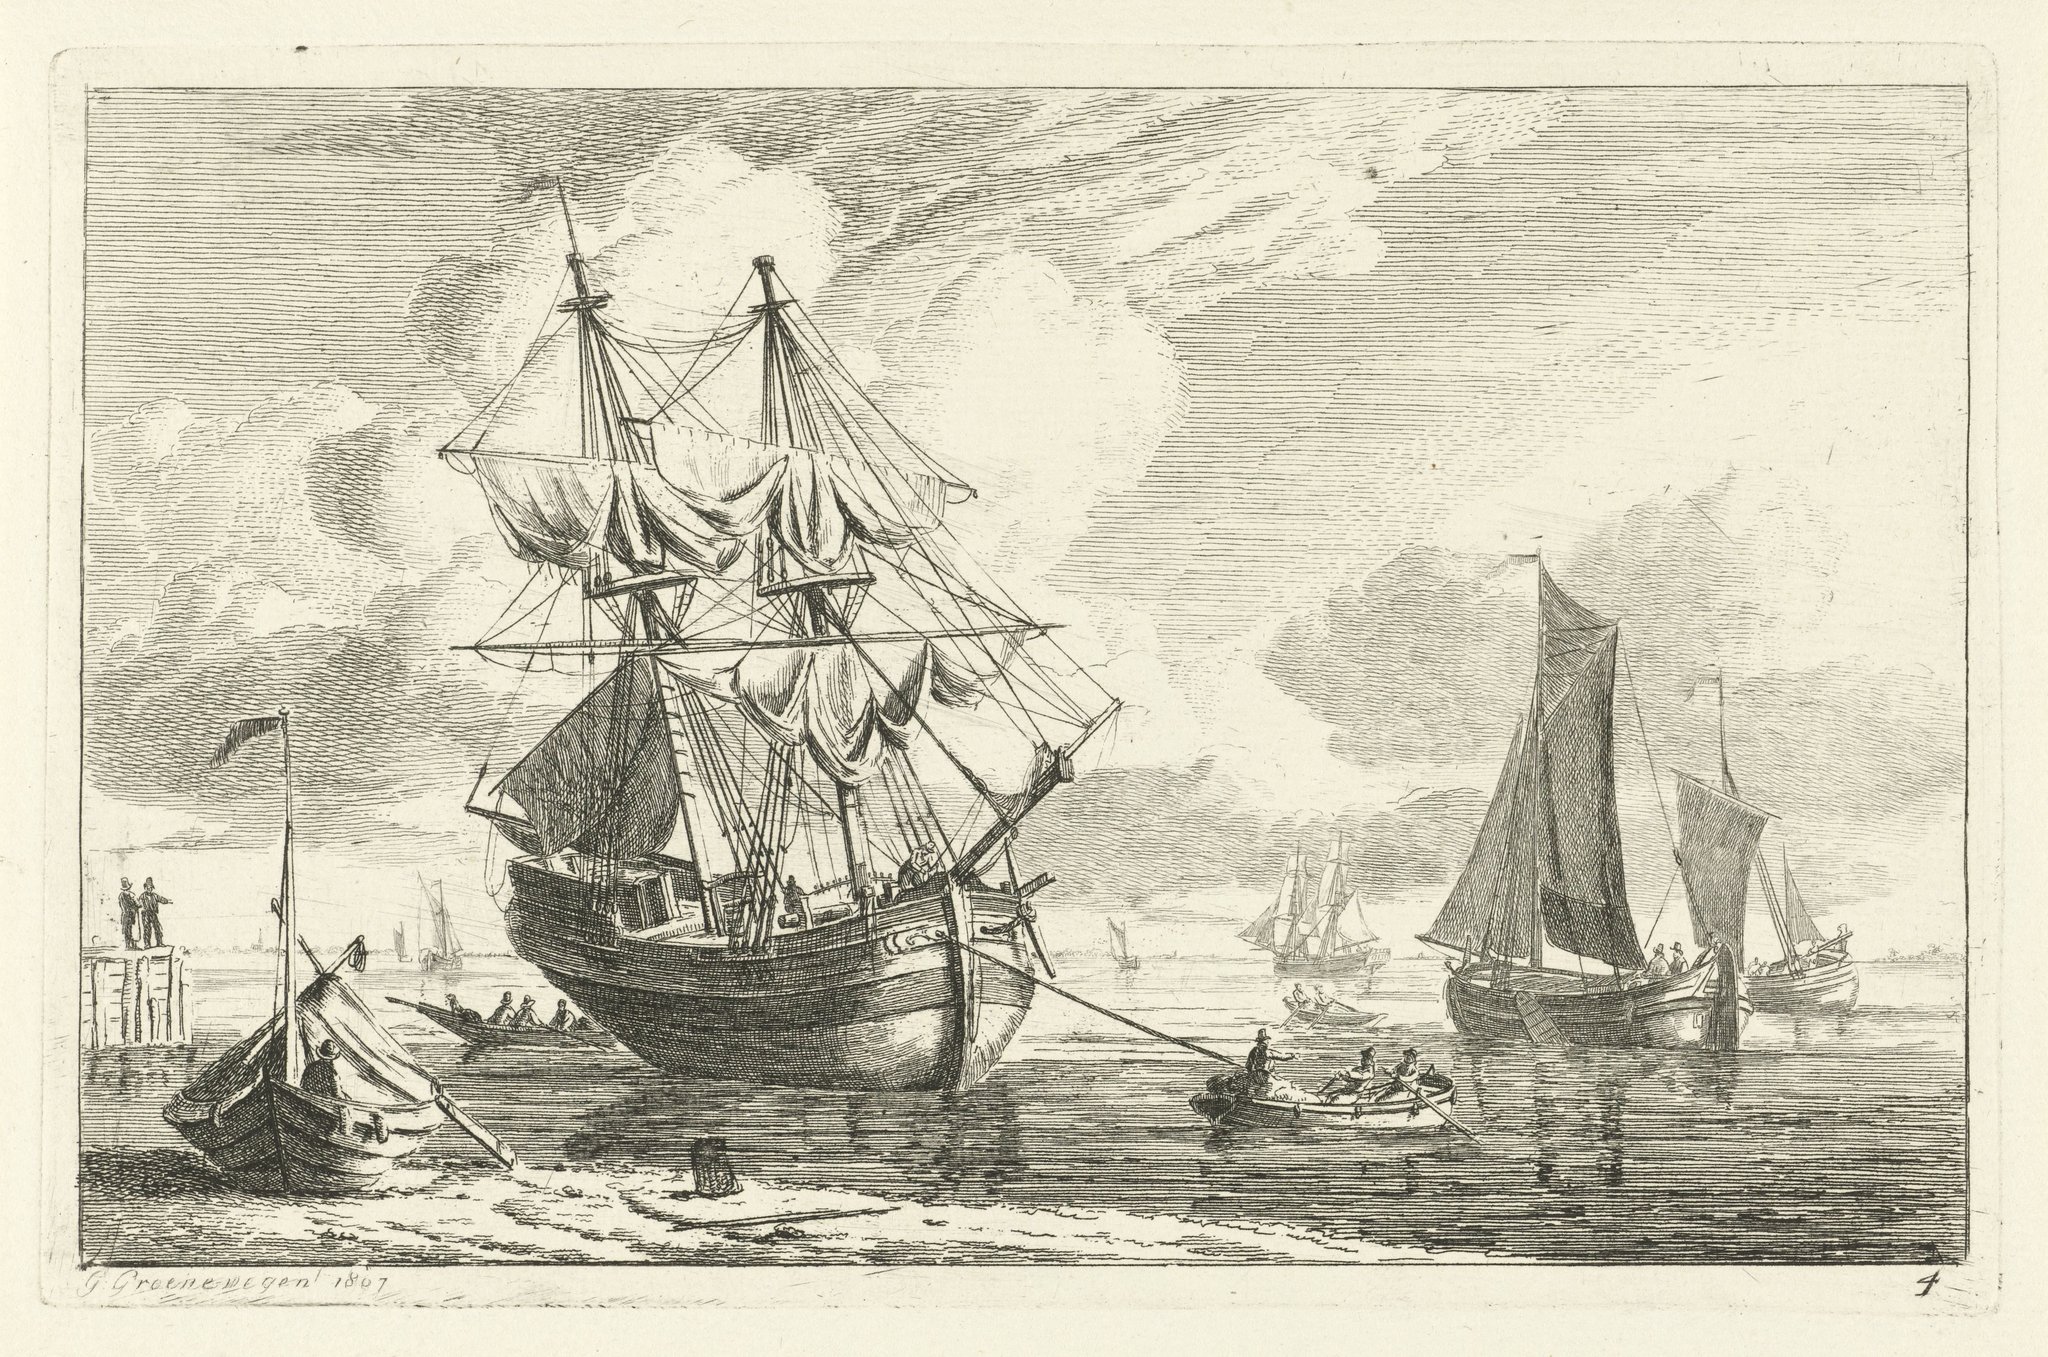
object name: print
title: Schip in ondiep water aan de grond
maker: gerrit groenewegen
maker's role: draughtsman, print maker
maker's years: 1754-1826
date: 1807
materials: paper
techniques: engraving, etching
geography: rotterdam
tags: ships (in general) - cc - more than one ship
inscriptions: collector's mark: Lugt 2228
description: Op de voorgrond is een zeilschip in ondiep water aan de grond gelopen. Rechts daarvan is een roeiboot afgebeeld. Op het strand ligt een drooggevallen boot. Op het water zijn verschillende zeilschepen en roeiboten te zien. Deze prent maakt deel uit van een serie van zes prenten met diverse schepen.